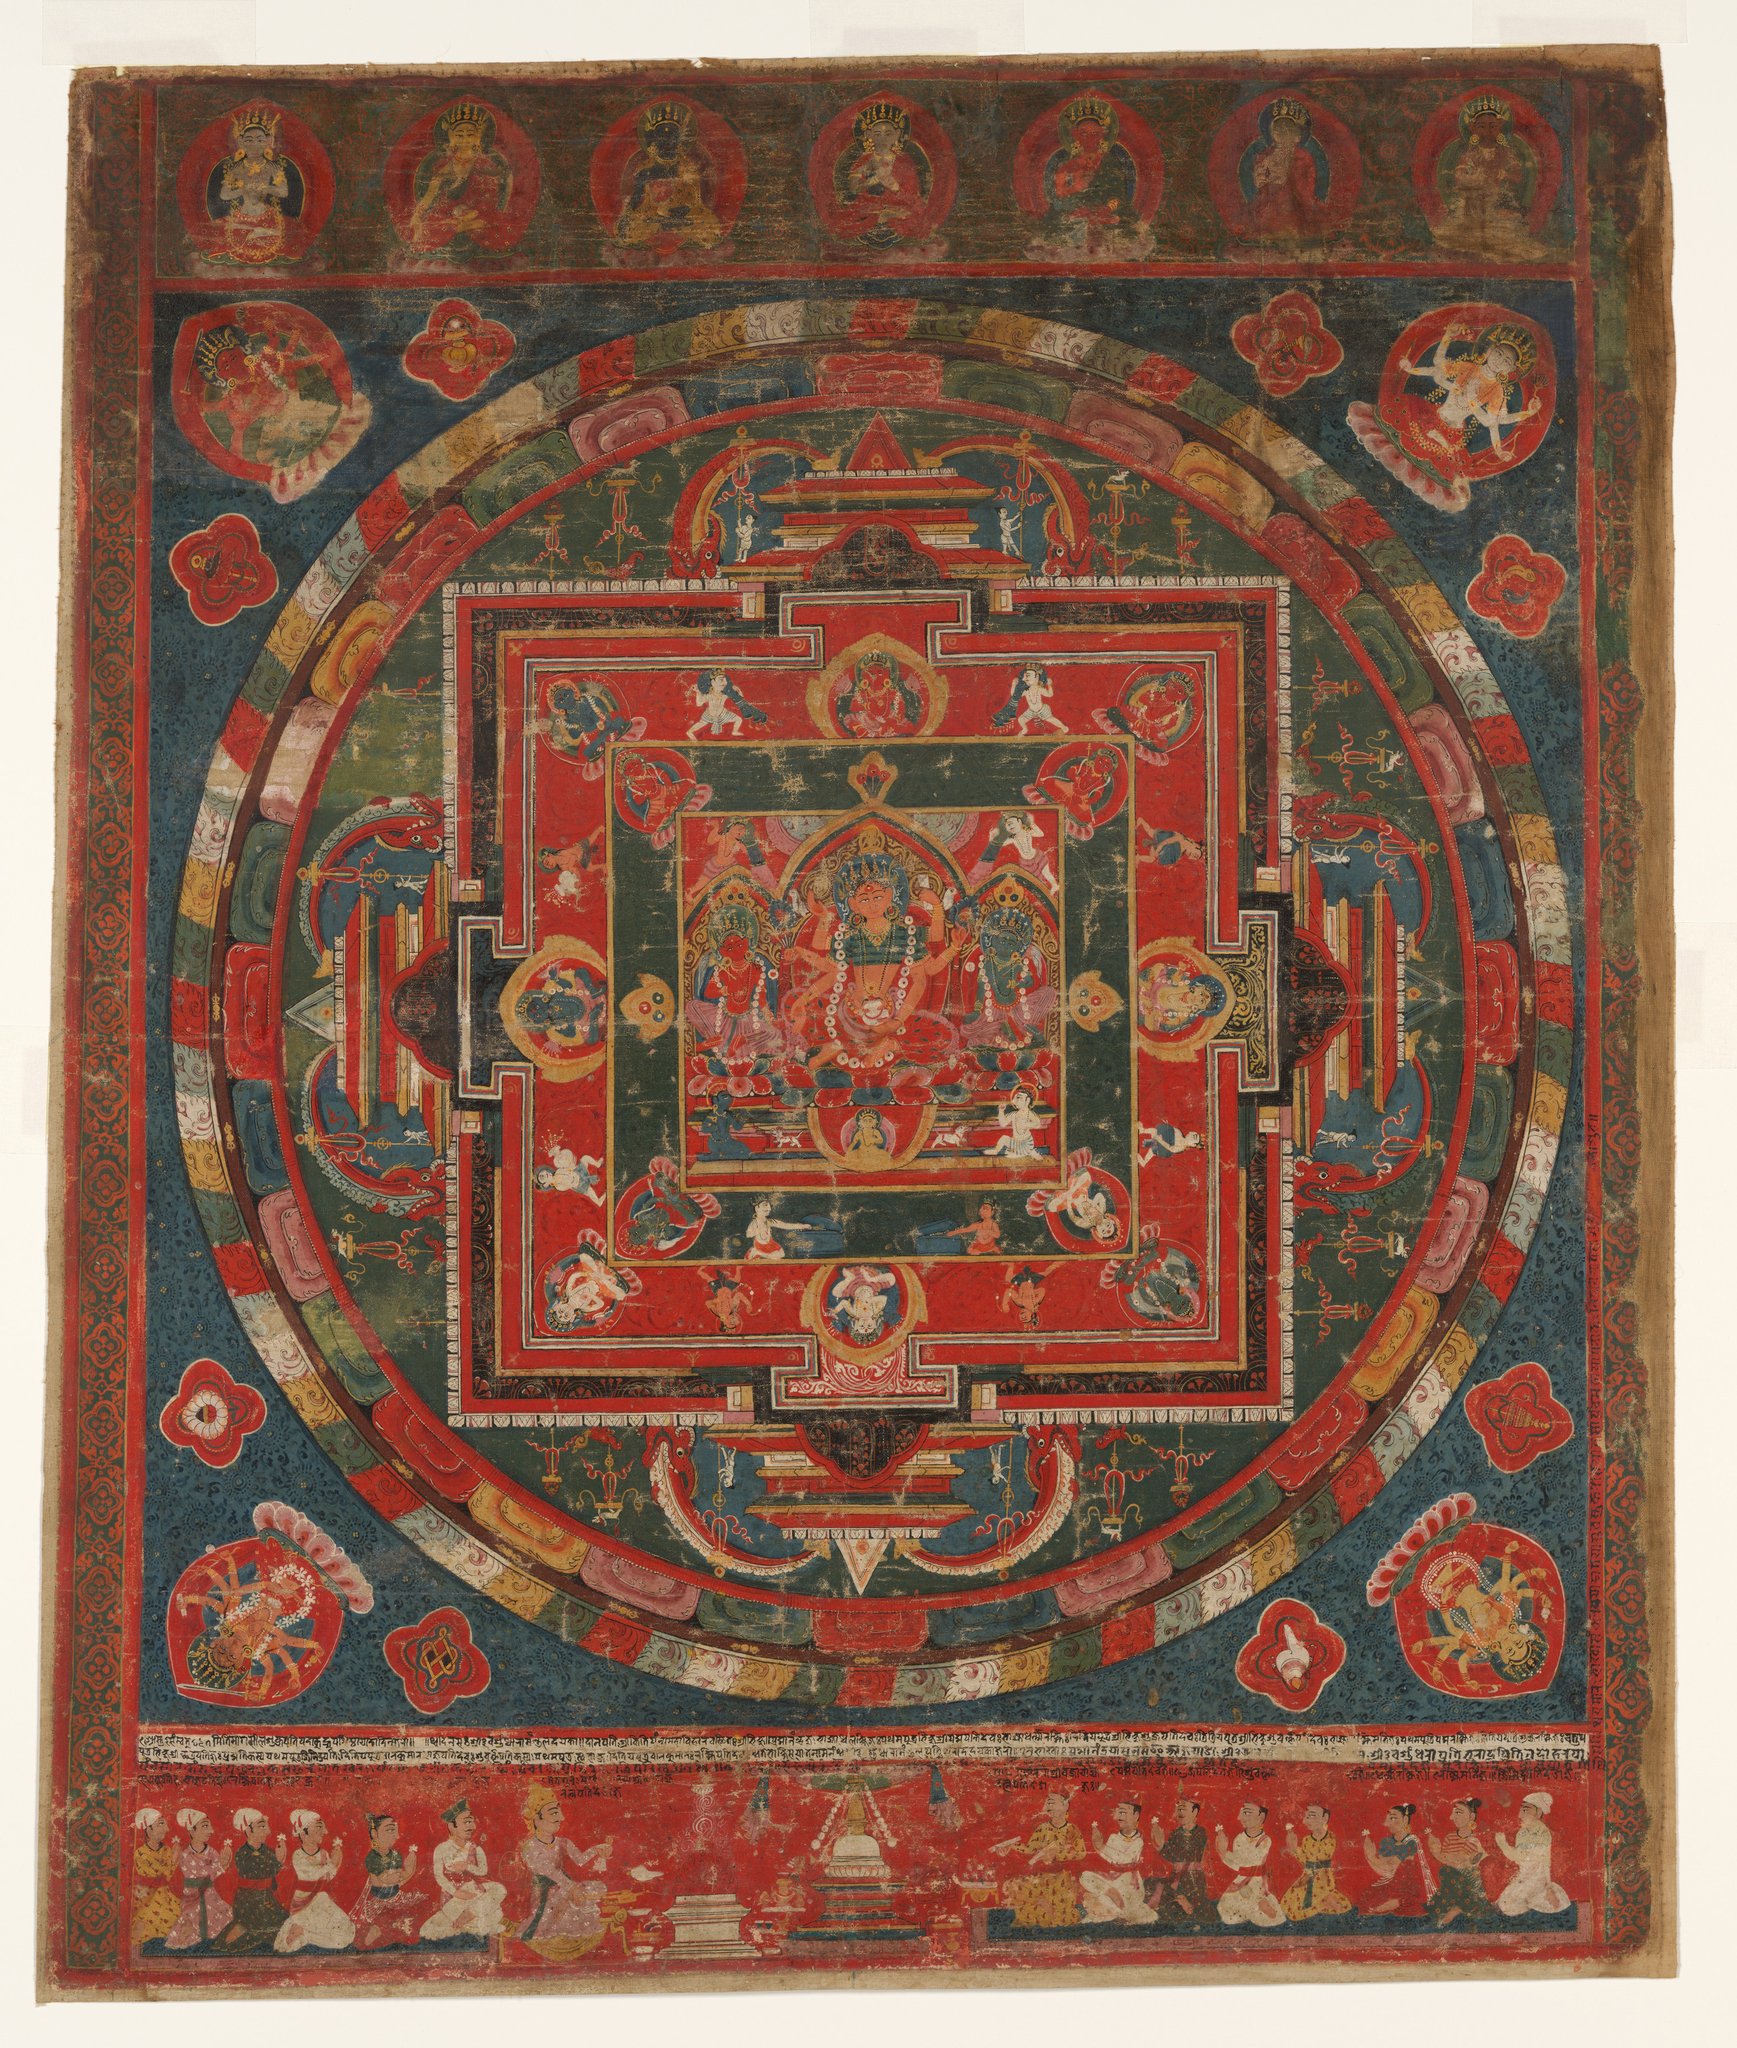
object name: thangka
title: Vasudhara Mandala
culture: nepali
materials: textile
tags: buddhism,bodhisattvas,vajrapani,goddess